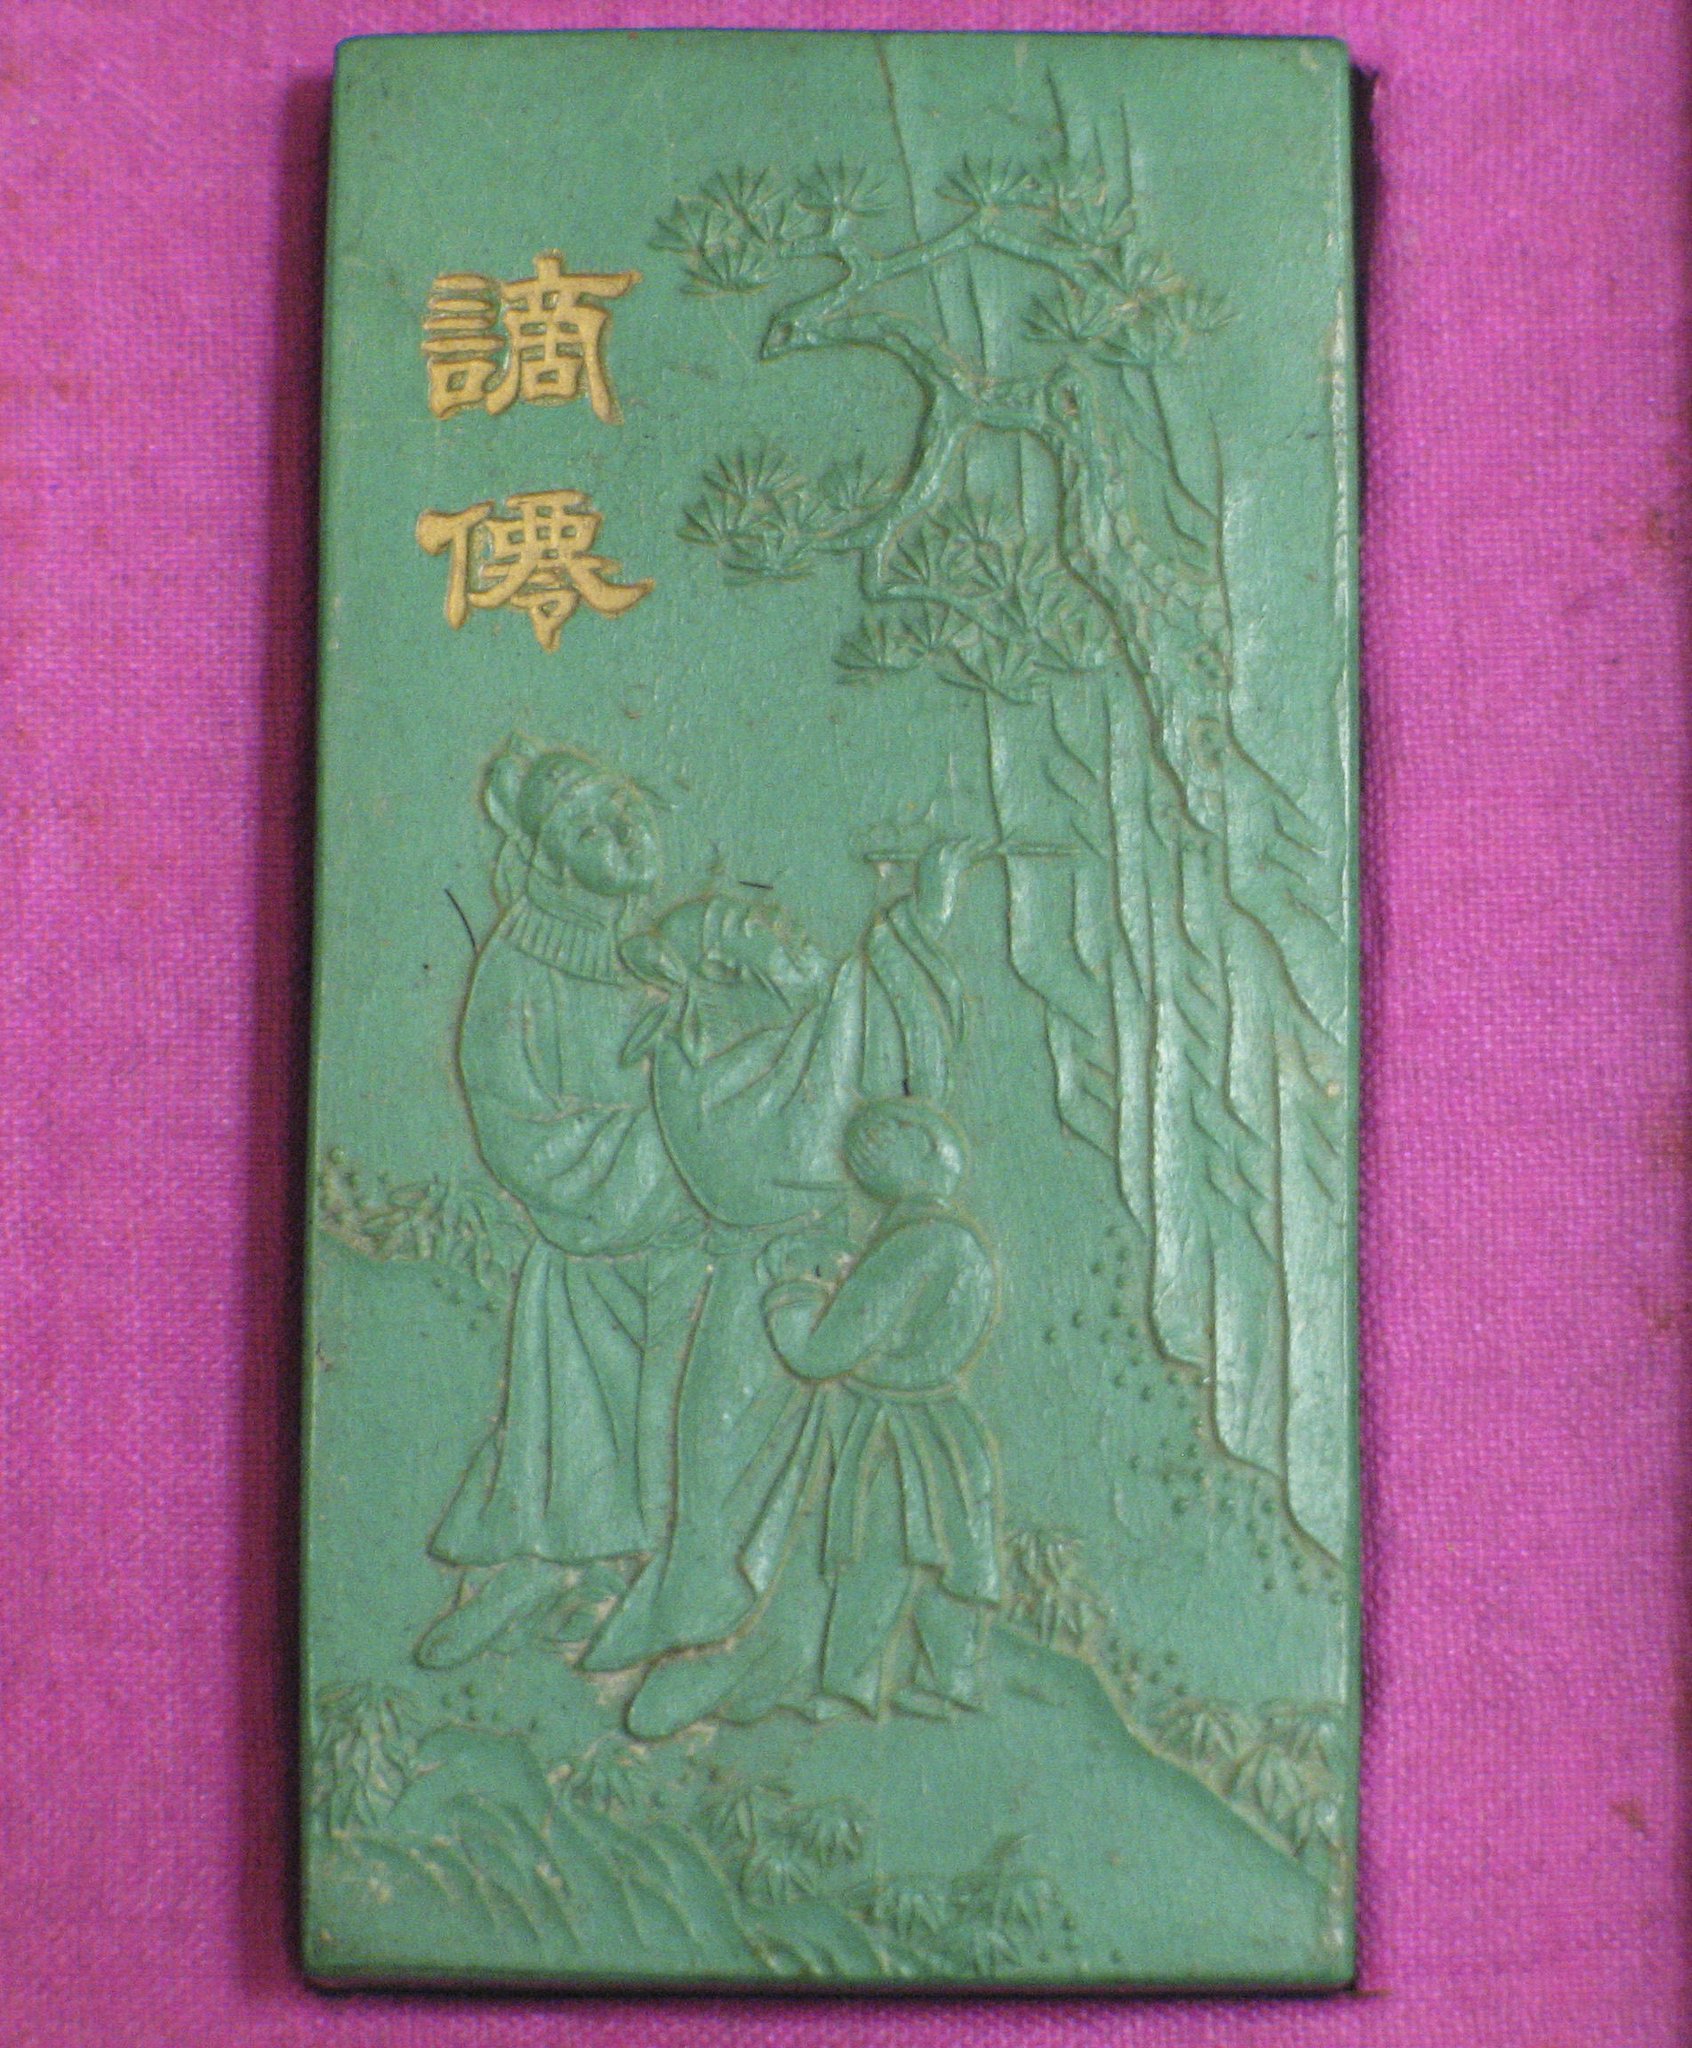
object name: ink tablet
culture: chinese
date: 1867-1933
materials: ink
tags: men,writing